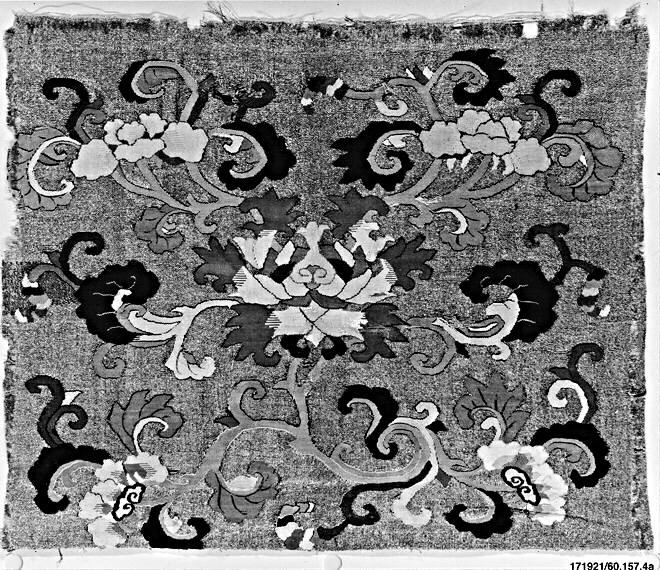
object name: piece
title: Panels with Scrolling Floral Design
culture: chinese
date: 1701-1800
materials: metal thread, silk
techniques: tapestry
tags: flowers